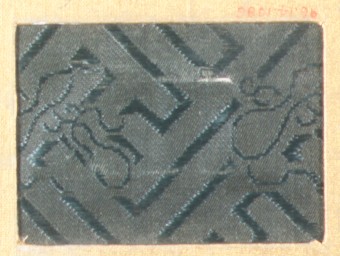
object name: piece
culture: japanese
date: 1701-1900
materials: silk